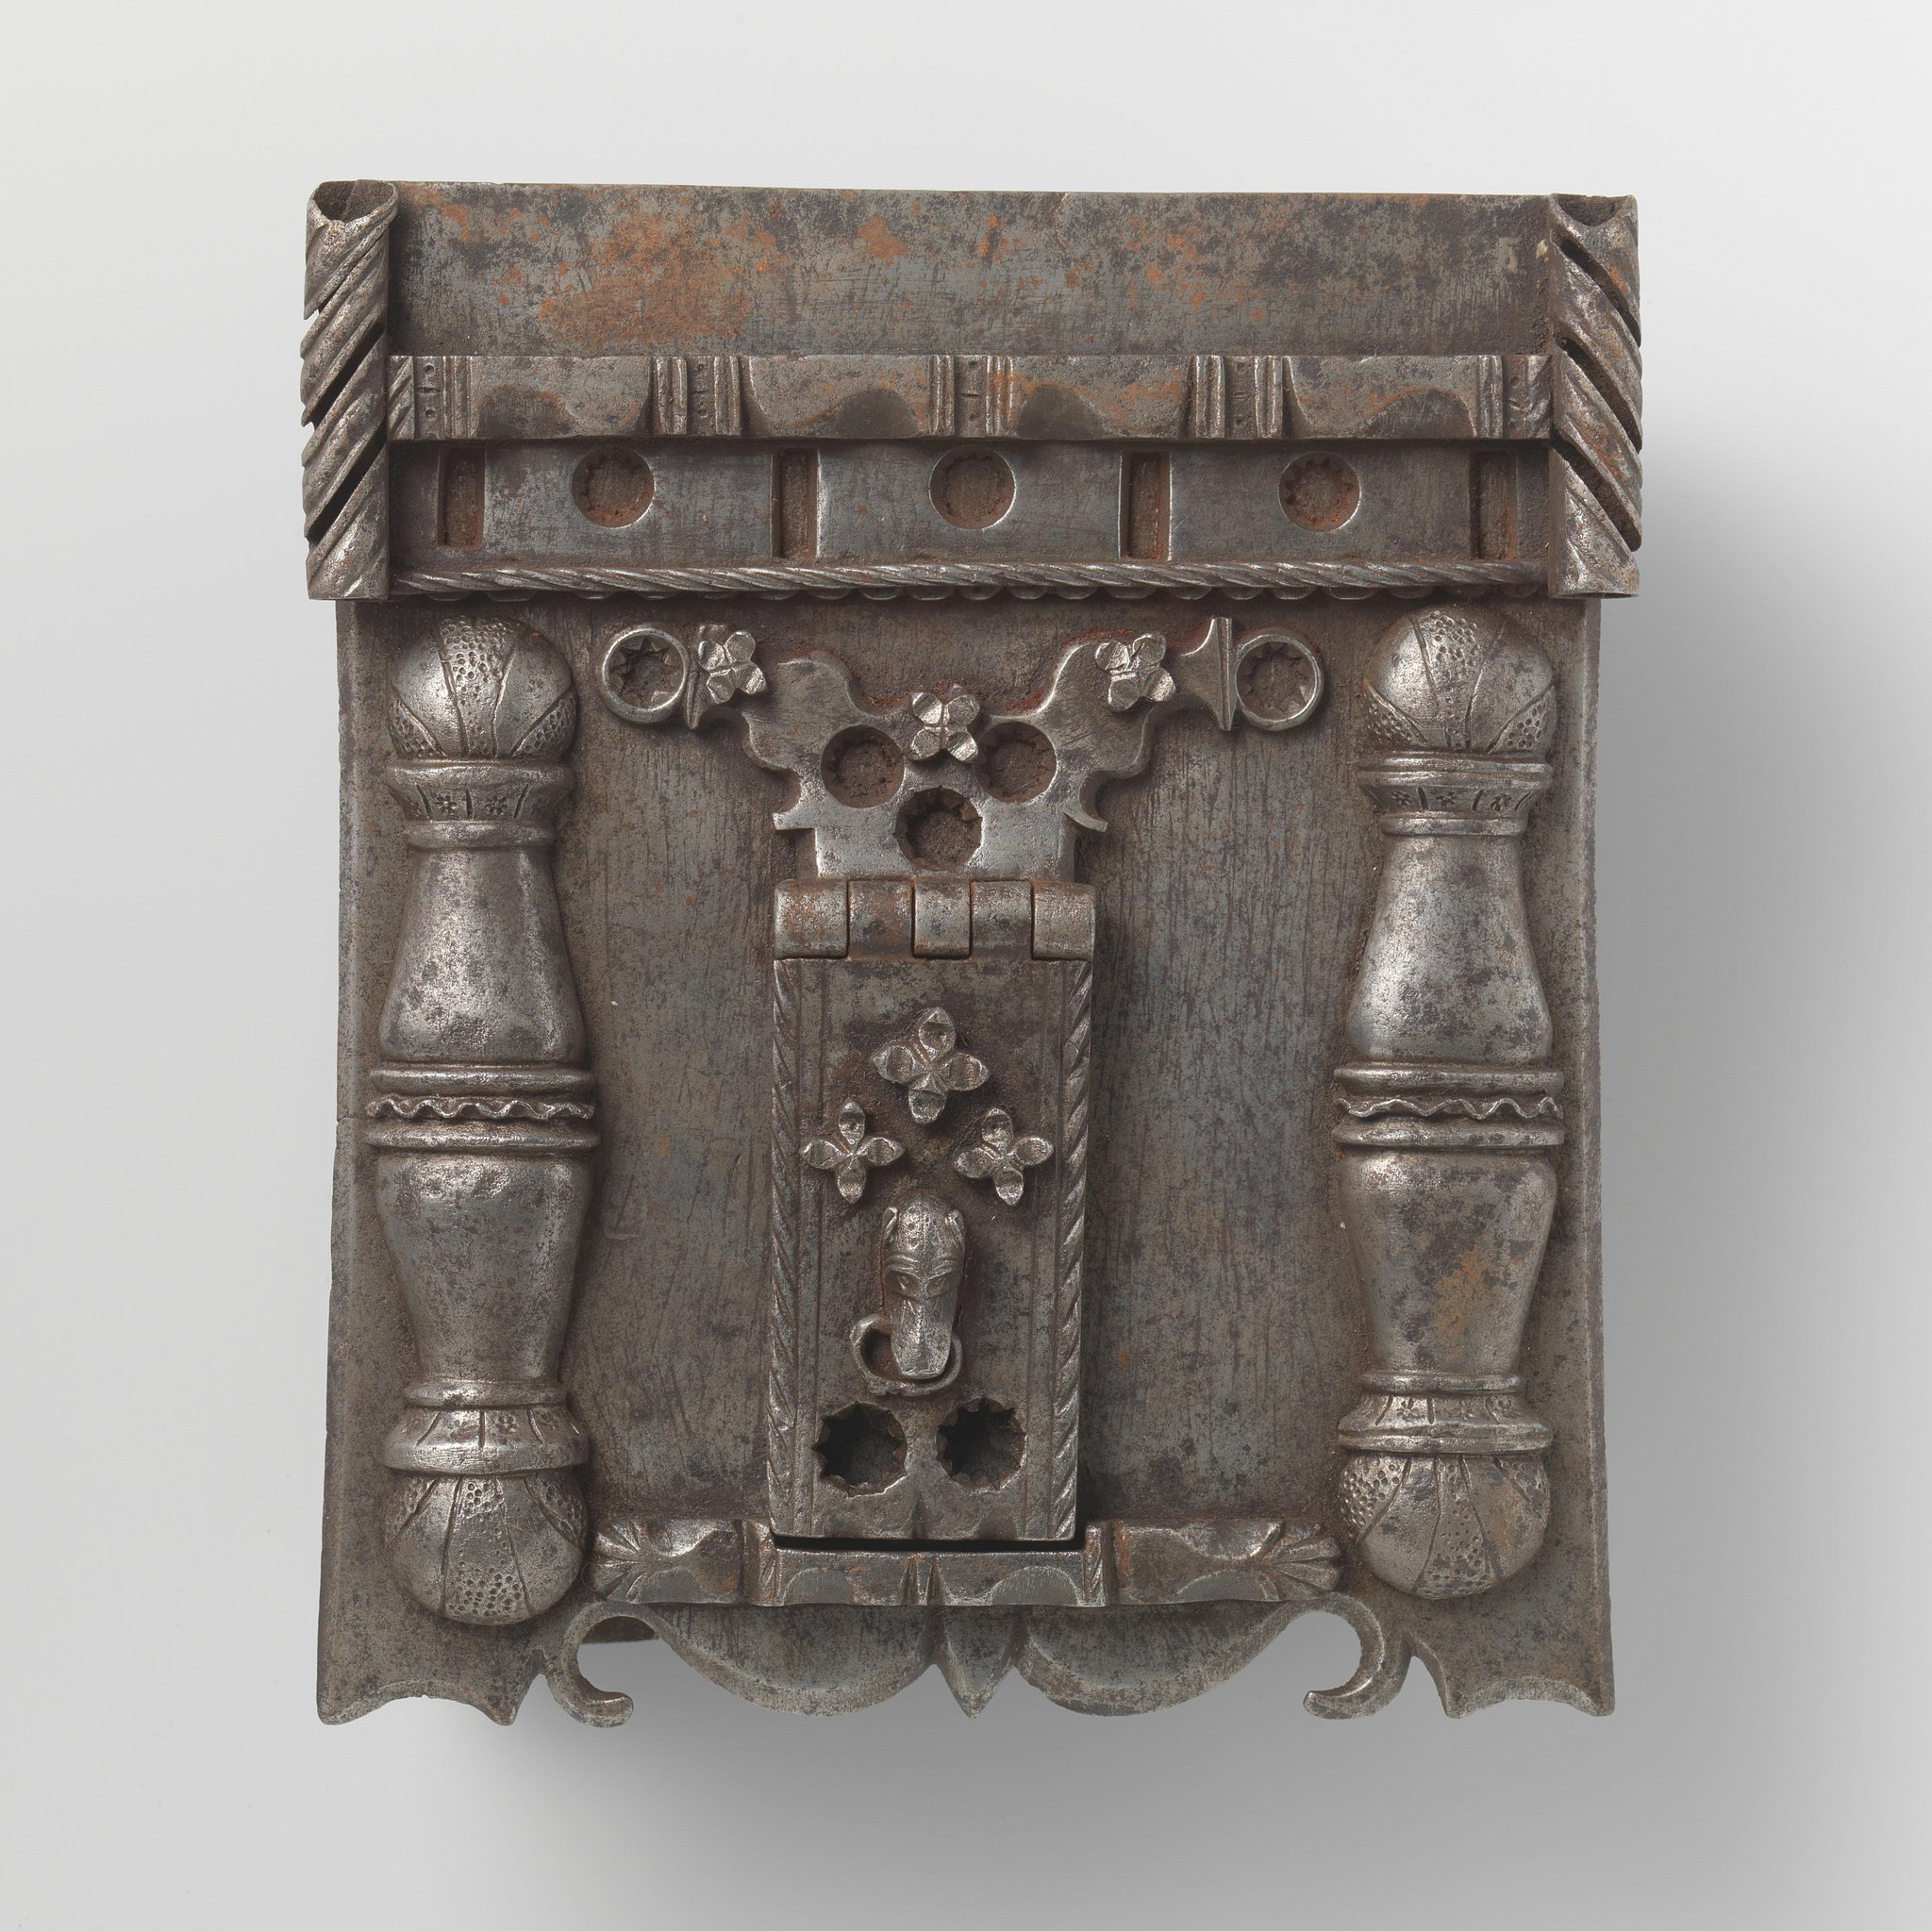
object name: lock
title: Chest lock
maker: Anonymous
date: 1500-1600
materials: iron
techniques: forging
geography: netherlands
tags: rosette ~ ornament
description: Een gesmeed ijzeren kistslot. Knijpsluiting met twee veeren. De slotplaat is versierd met twee halve colonetten, waaraan de schroefbouten zijn bevestigd. Hierboven een fries met vijlwerk. Het sleutelgat wordt bedekt door een val met geheimsluiting. (Een verschuifbare knip met hondenkop, die een ring in de bak houdt, wordt tegengehouden door drie draaibare schijven, die aan een zijde ingekeept zijn. Aan de buitenzijde vertonen deze schijven rozetten).